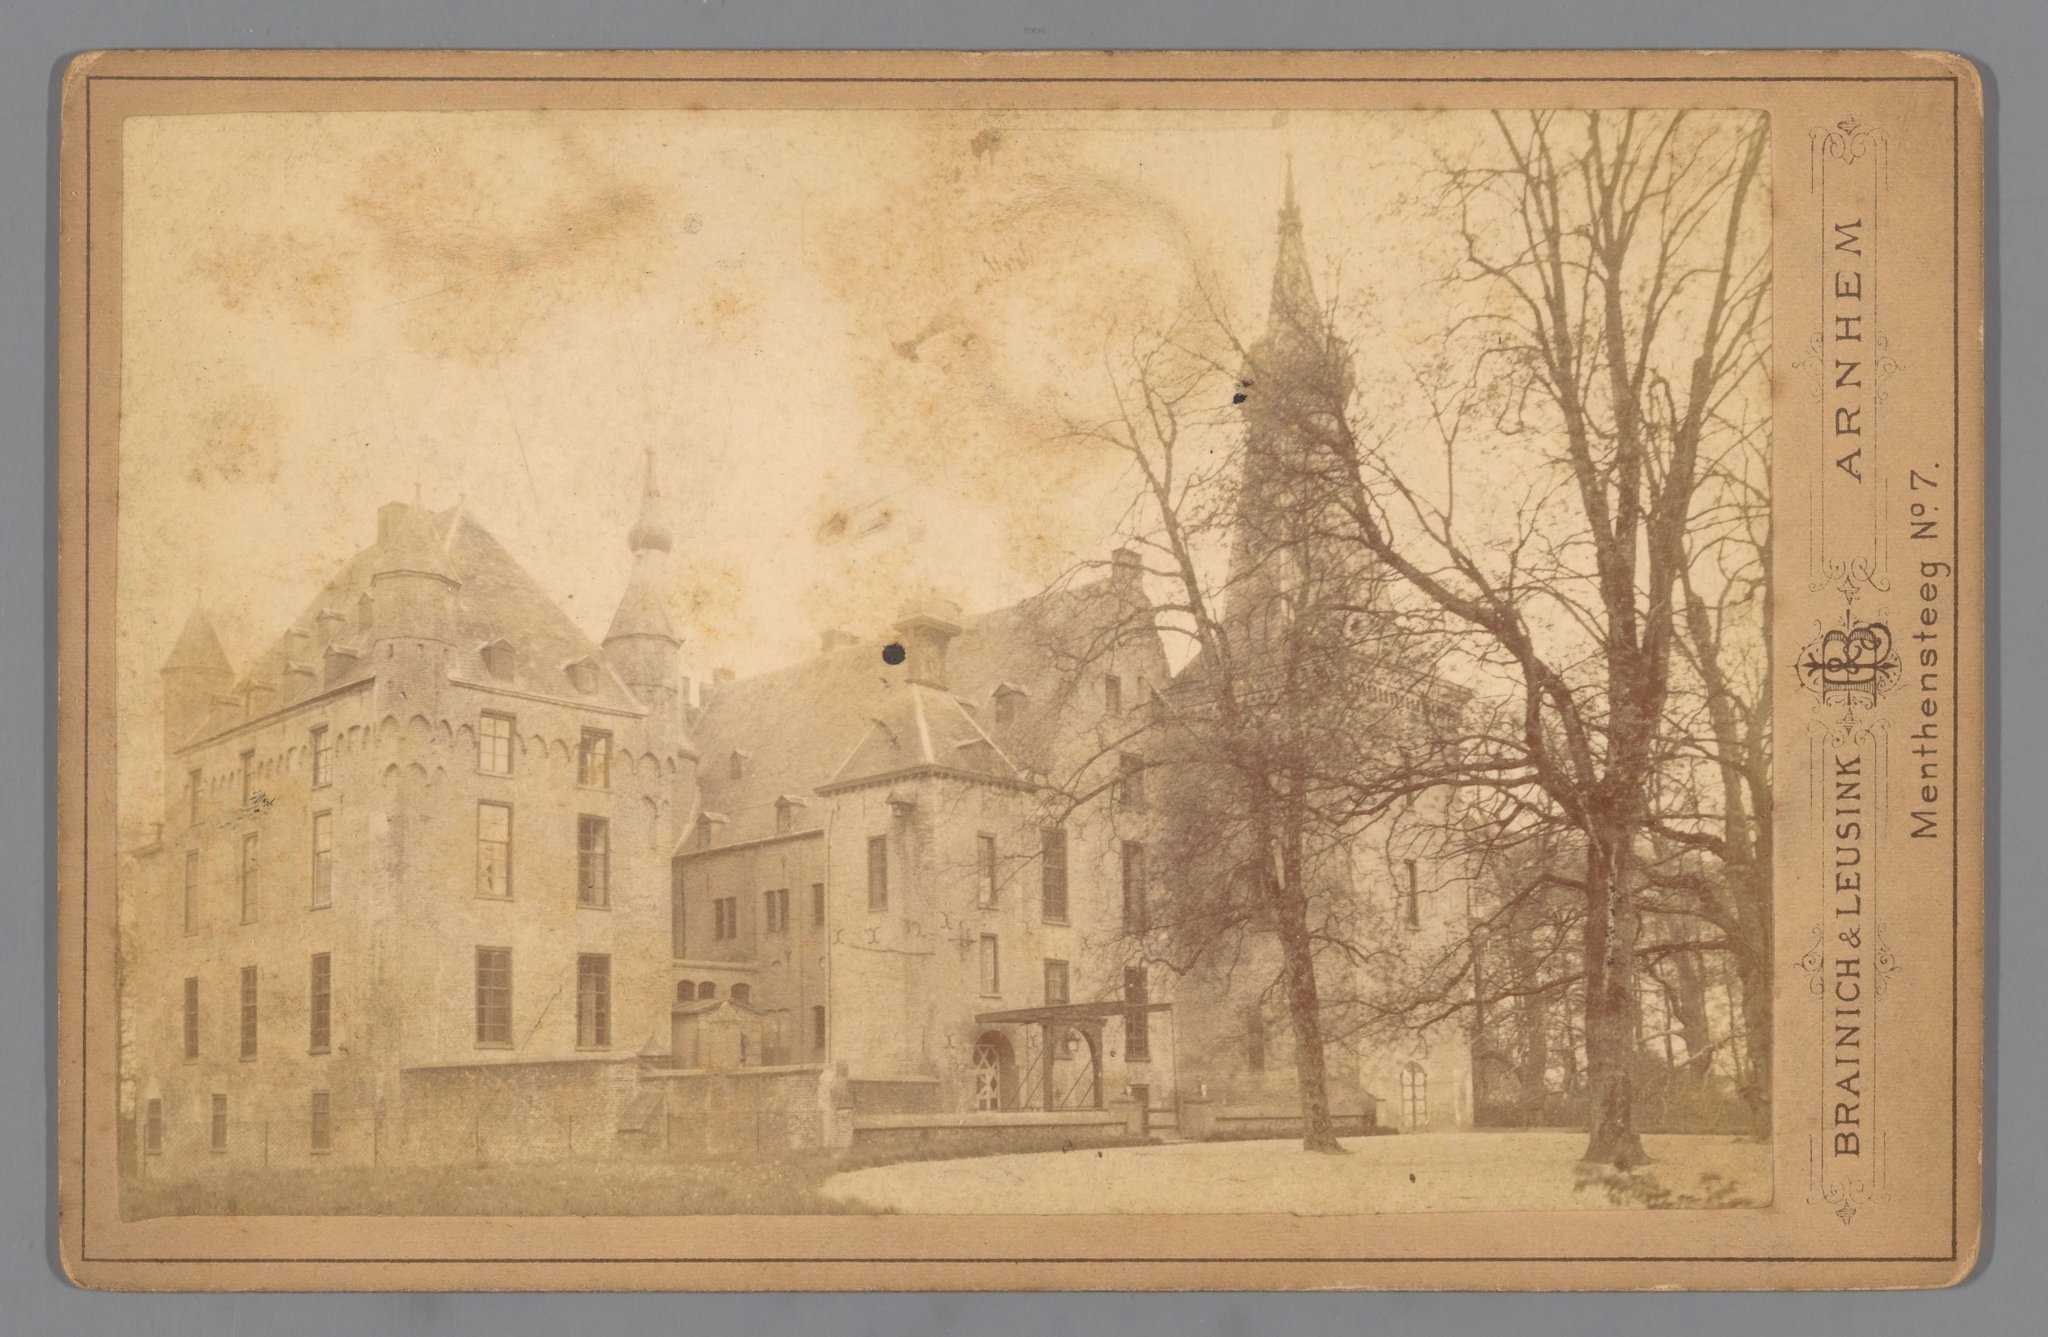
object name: cabinet photograph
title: Gezicht op Kasteel Doorwerth in Doorwerth, Gelderland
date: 1881-1906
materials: cardboard, photographic support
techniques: albumen print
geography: doorwerth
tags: castle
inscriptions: address: ‘BRAINICH & LEUSINK ARNHEM/ Menthensteeg No. 7.’